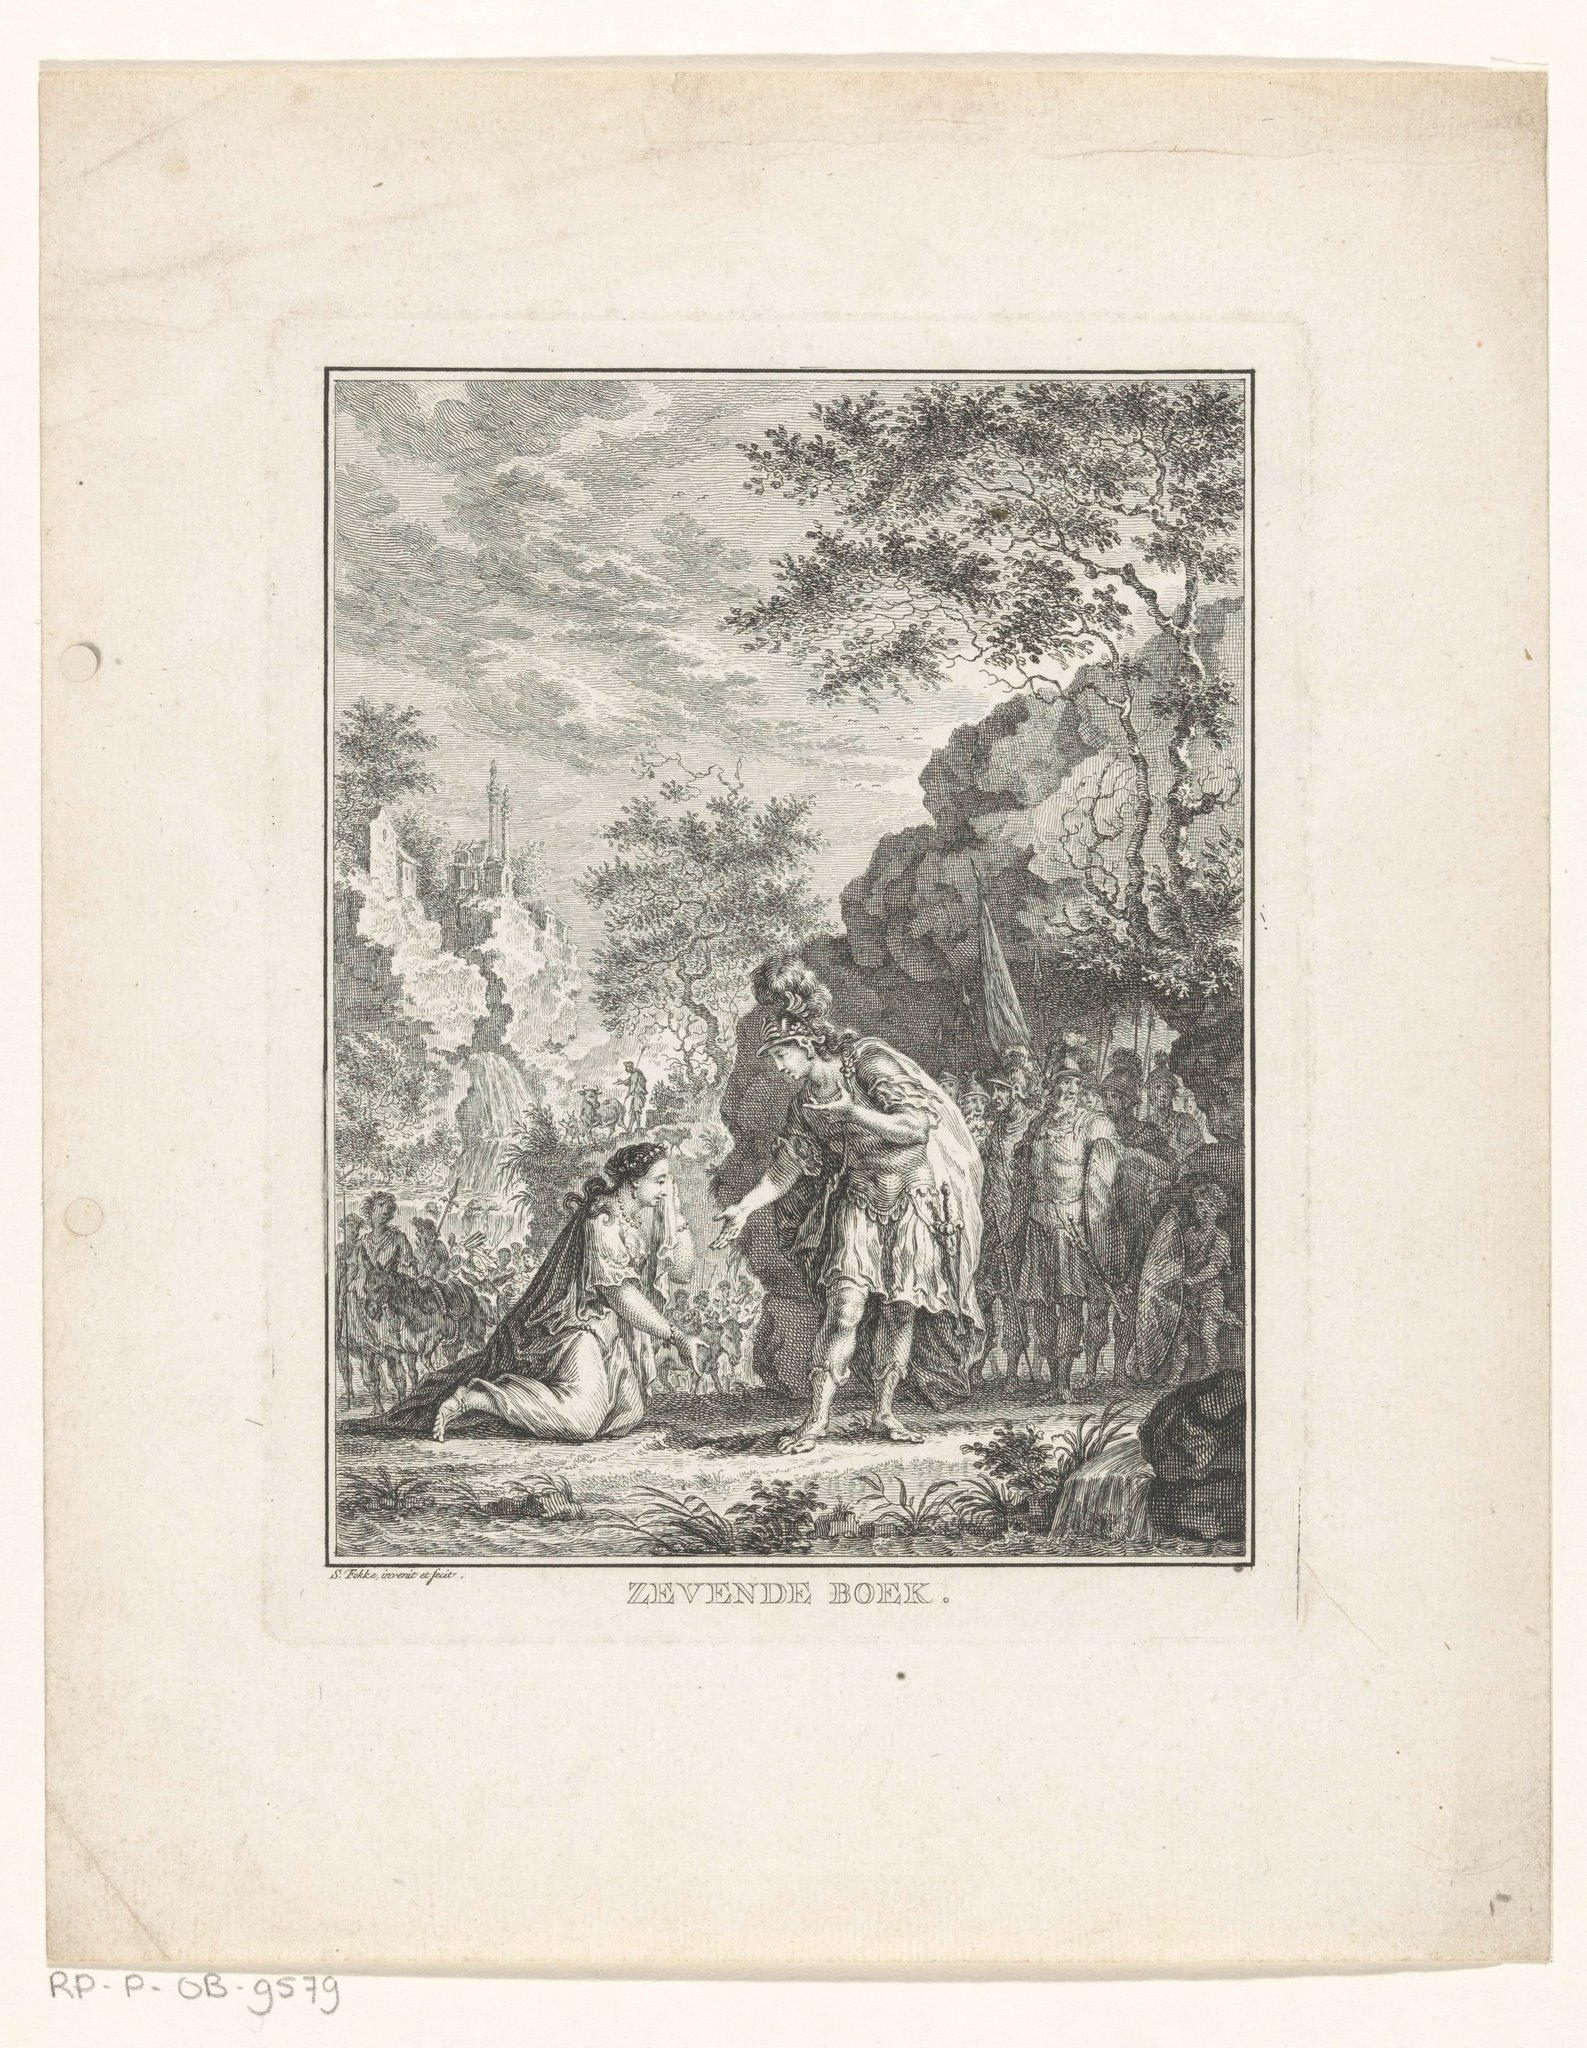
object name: book illustration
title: David en Saul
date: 1766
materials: paper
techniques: etching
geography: amsterdam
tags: meeting of david and abigail, who kneels before him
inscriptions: collector's mark: Lugt 2228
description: Abigaïl knielt met een zakdoek in haar hand voor haar toekomstige echtgenoot David. Op zijn beurt buigt David met uitgestoken hand naar haar toe. Achter David wachten soldaten bij een rots, achter Abigaïl staat een groep mensen met bepakte ezels.